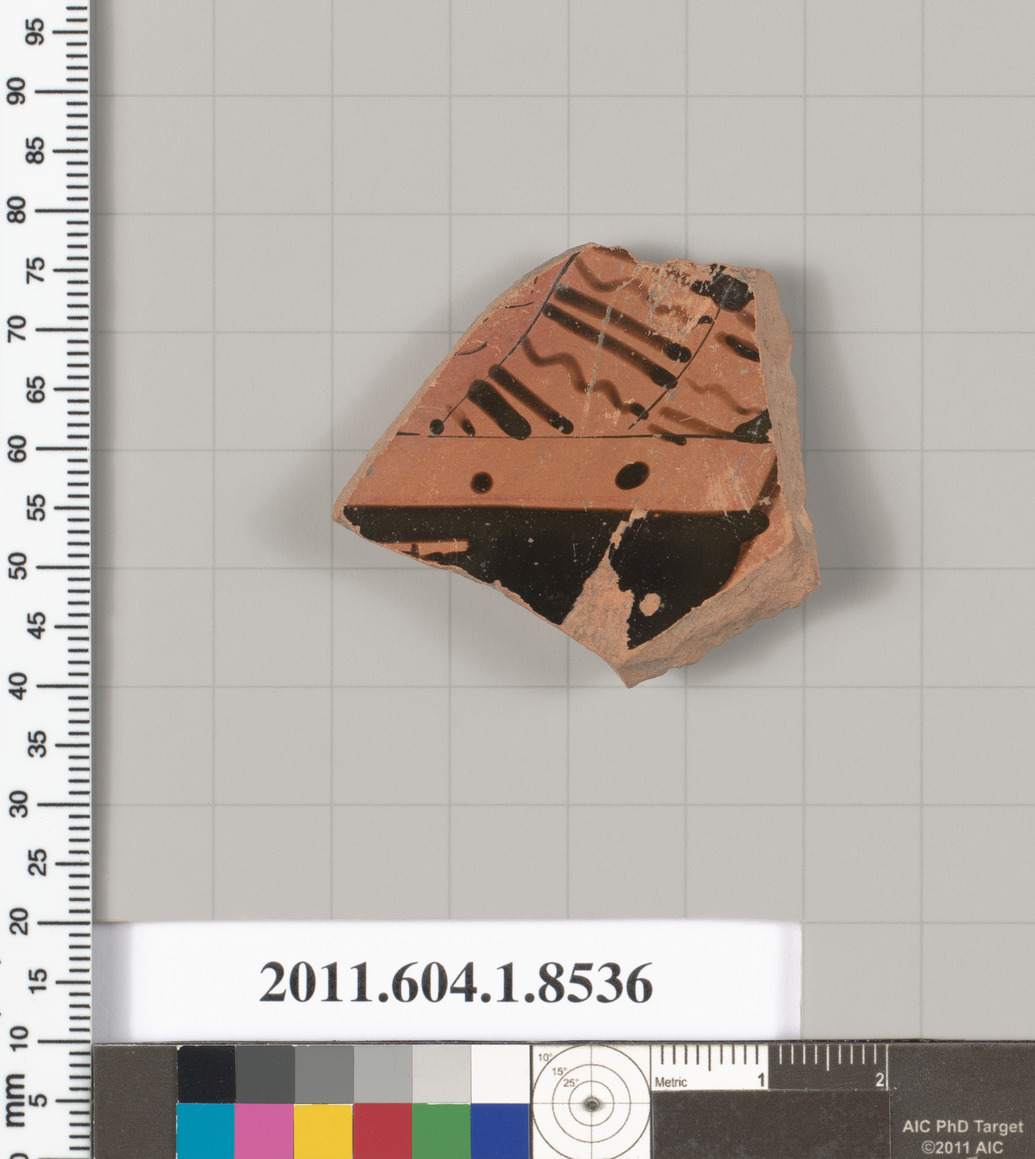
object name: kylix fragment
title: Terracotta fragment of a stemless kylix (drinking cup)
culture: greek, attic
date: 467-435 BCE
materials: terracotta